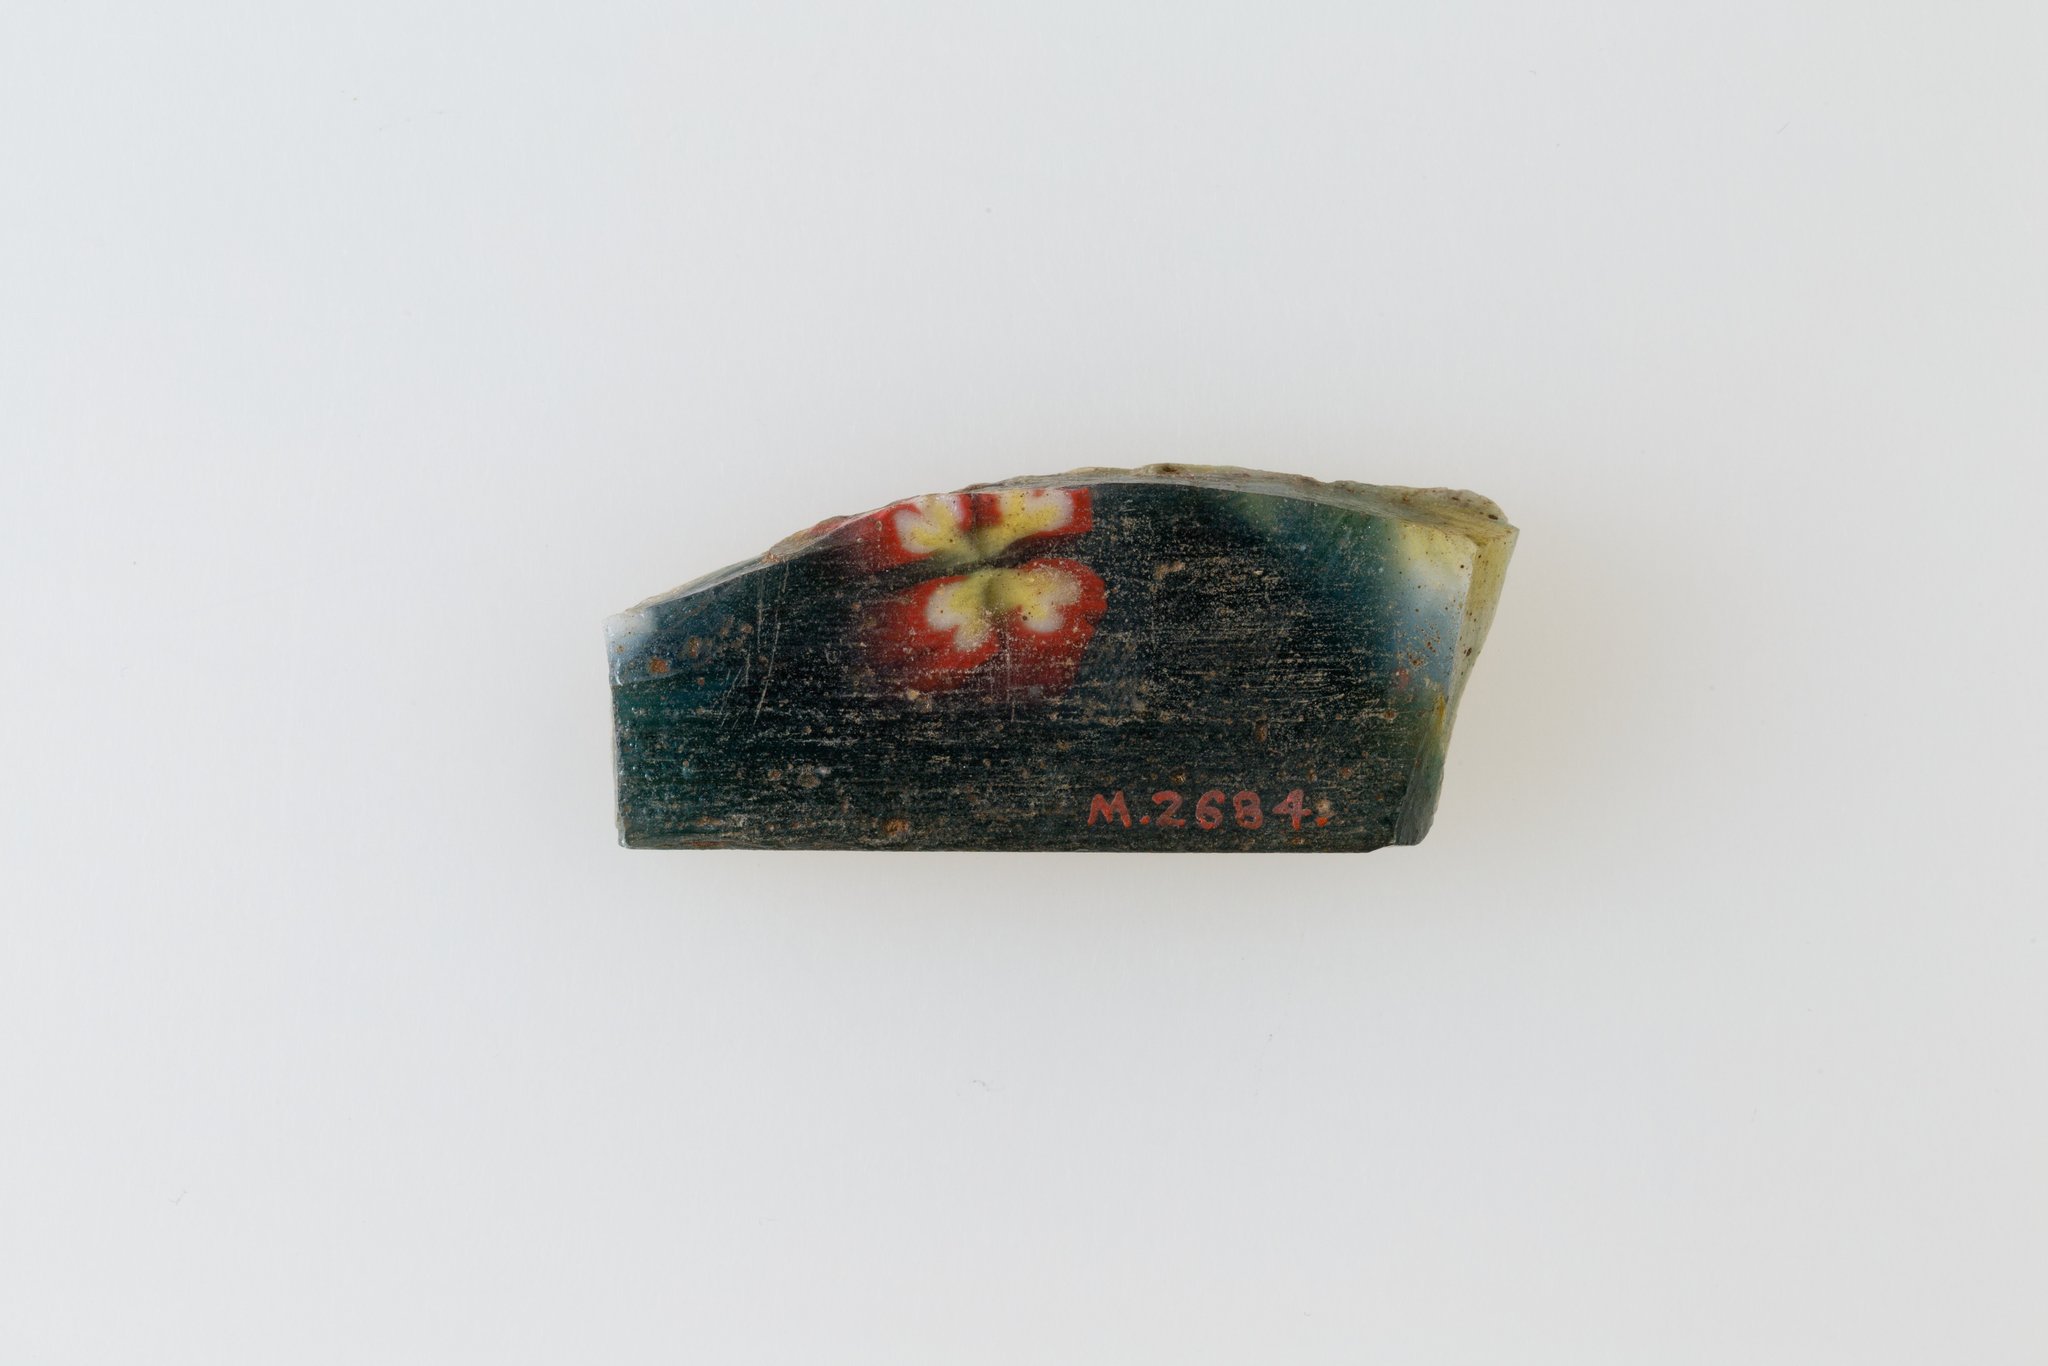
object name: plaque, floral, inlay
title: Floral plaque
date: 100 BCE-100 CE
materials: glass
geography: egypt